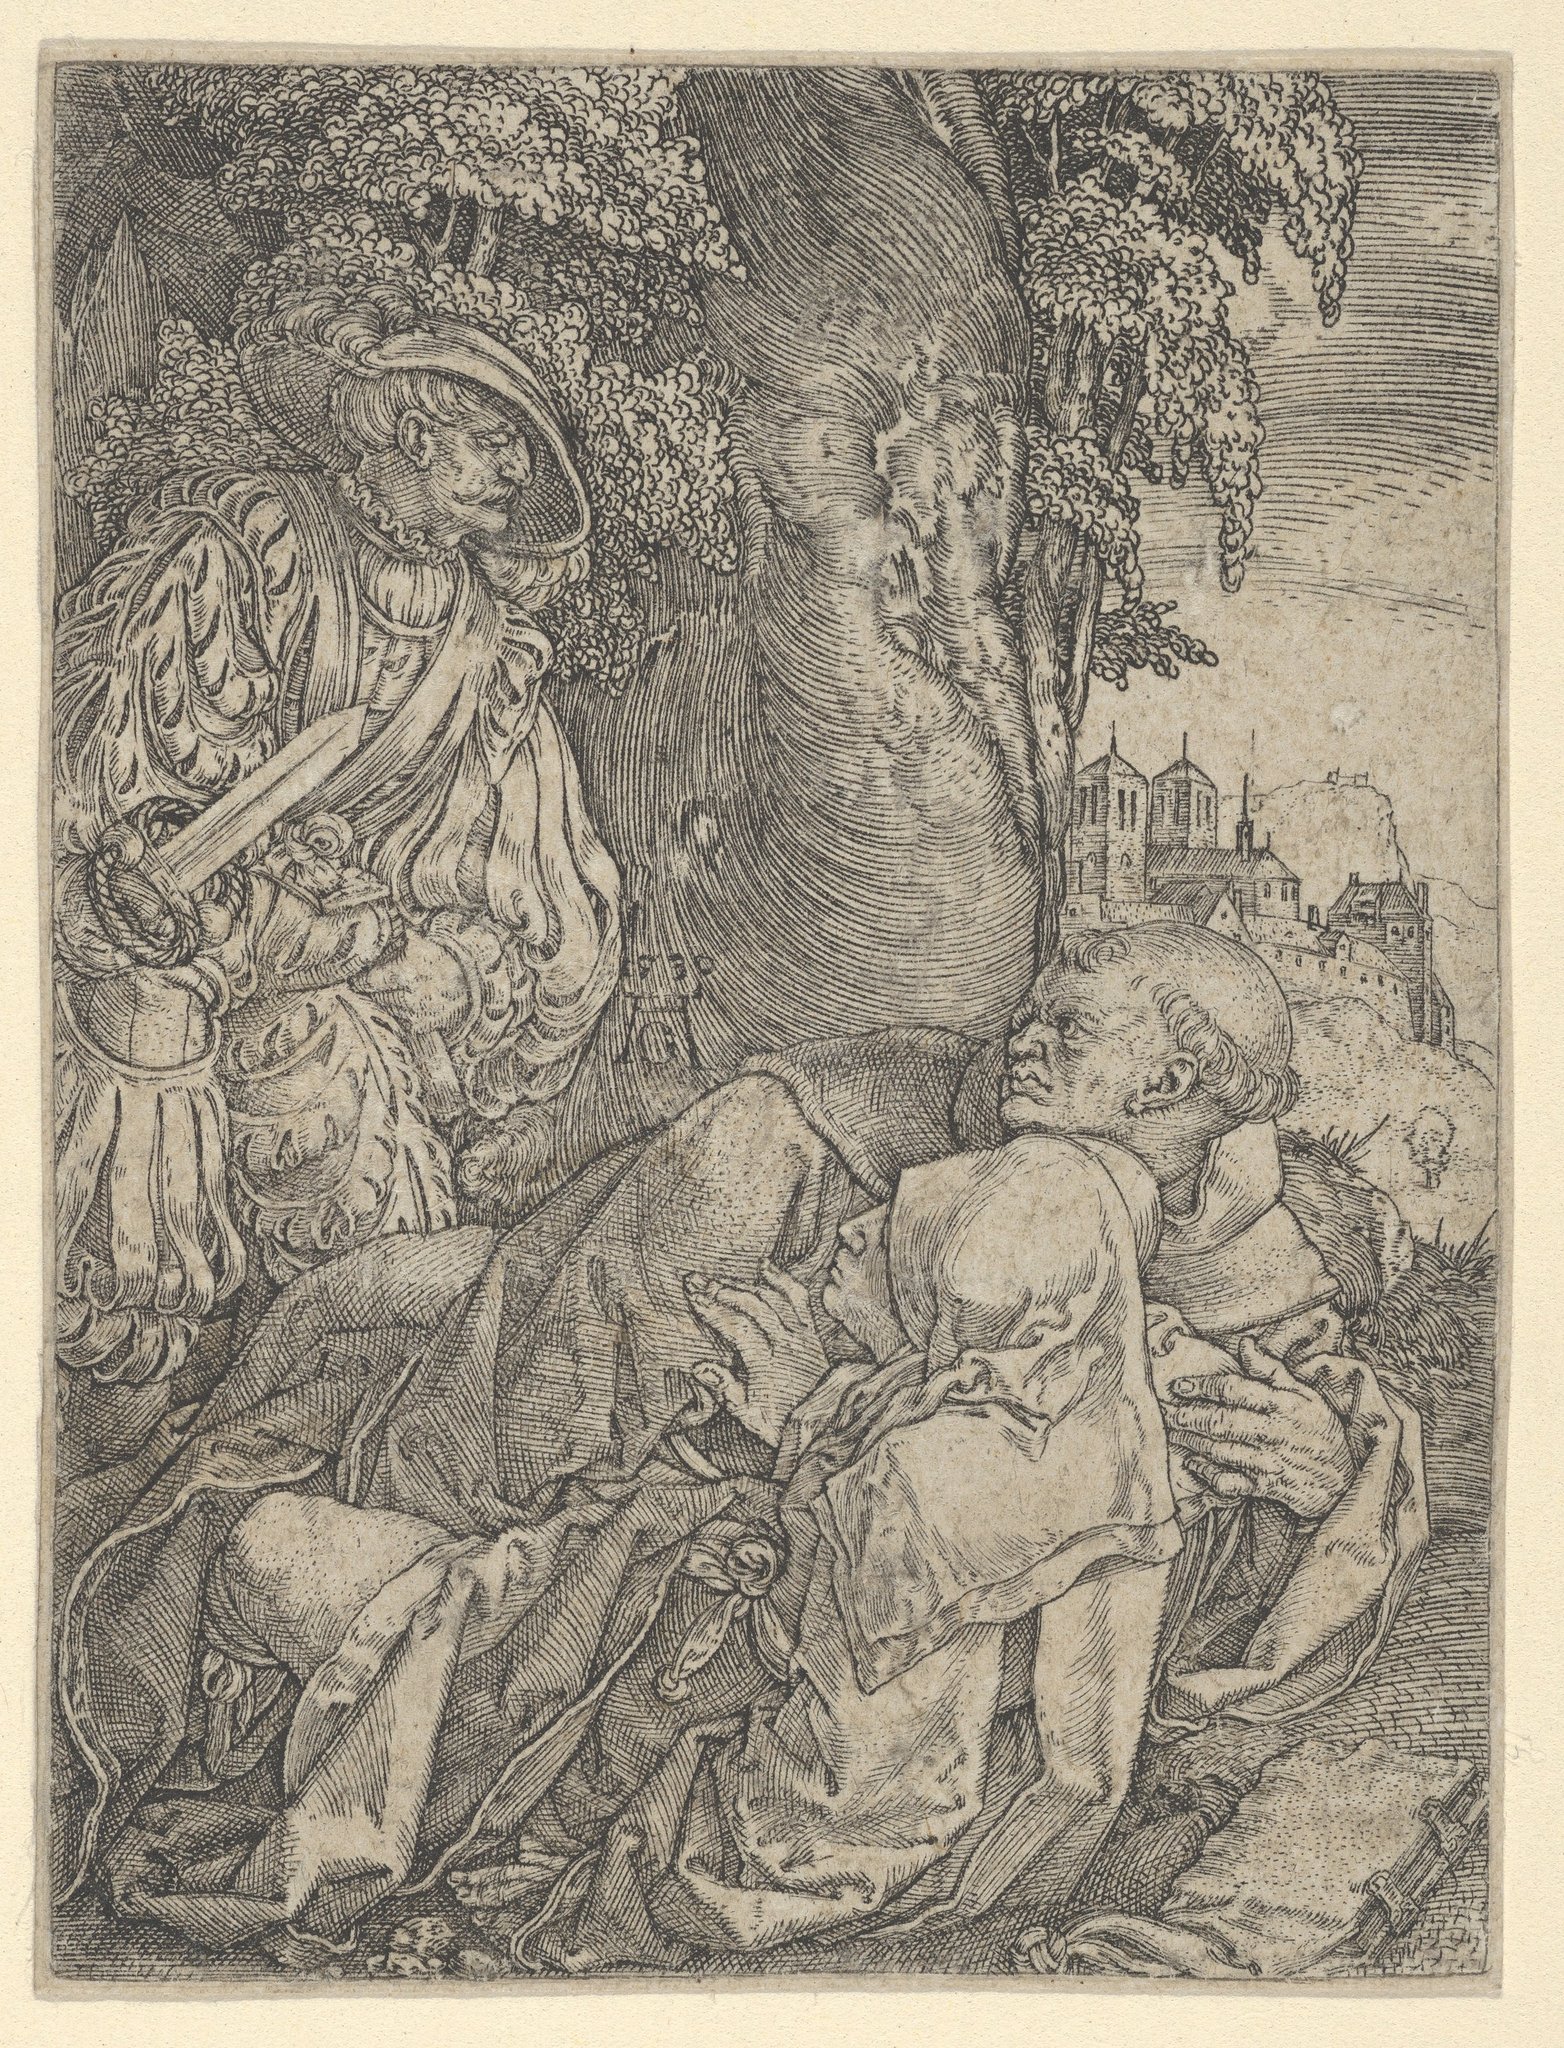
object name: print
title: The Monk and the Nun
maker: heinrich aldegrever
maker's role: artist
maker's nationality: german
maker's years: 1502-1561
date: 1530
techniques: engraving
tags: knives,men,women,monks